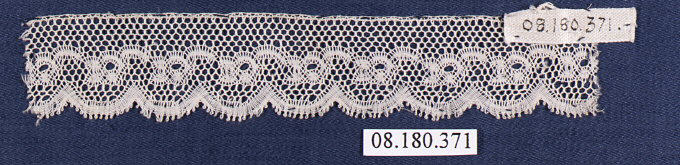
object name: piece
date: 1701-1800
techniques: lace